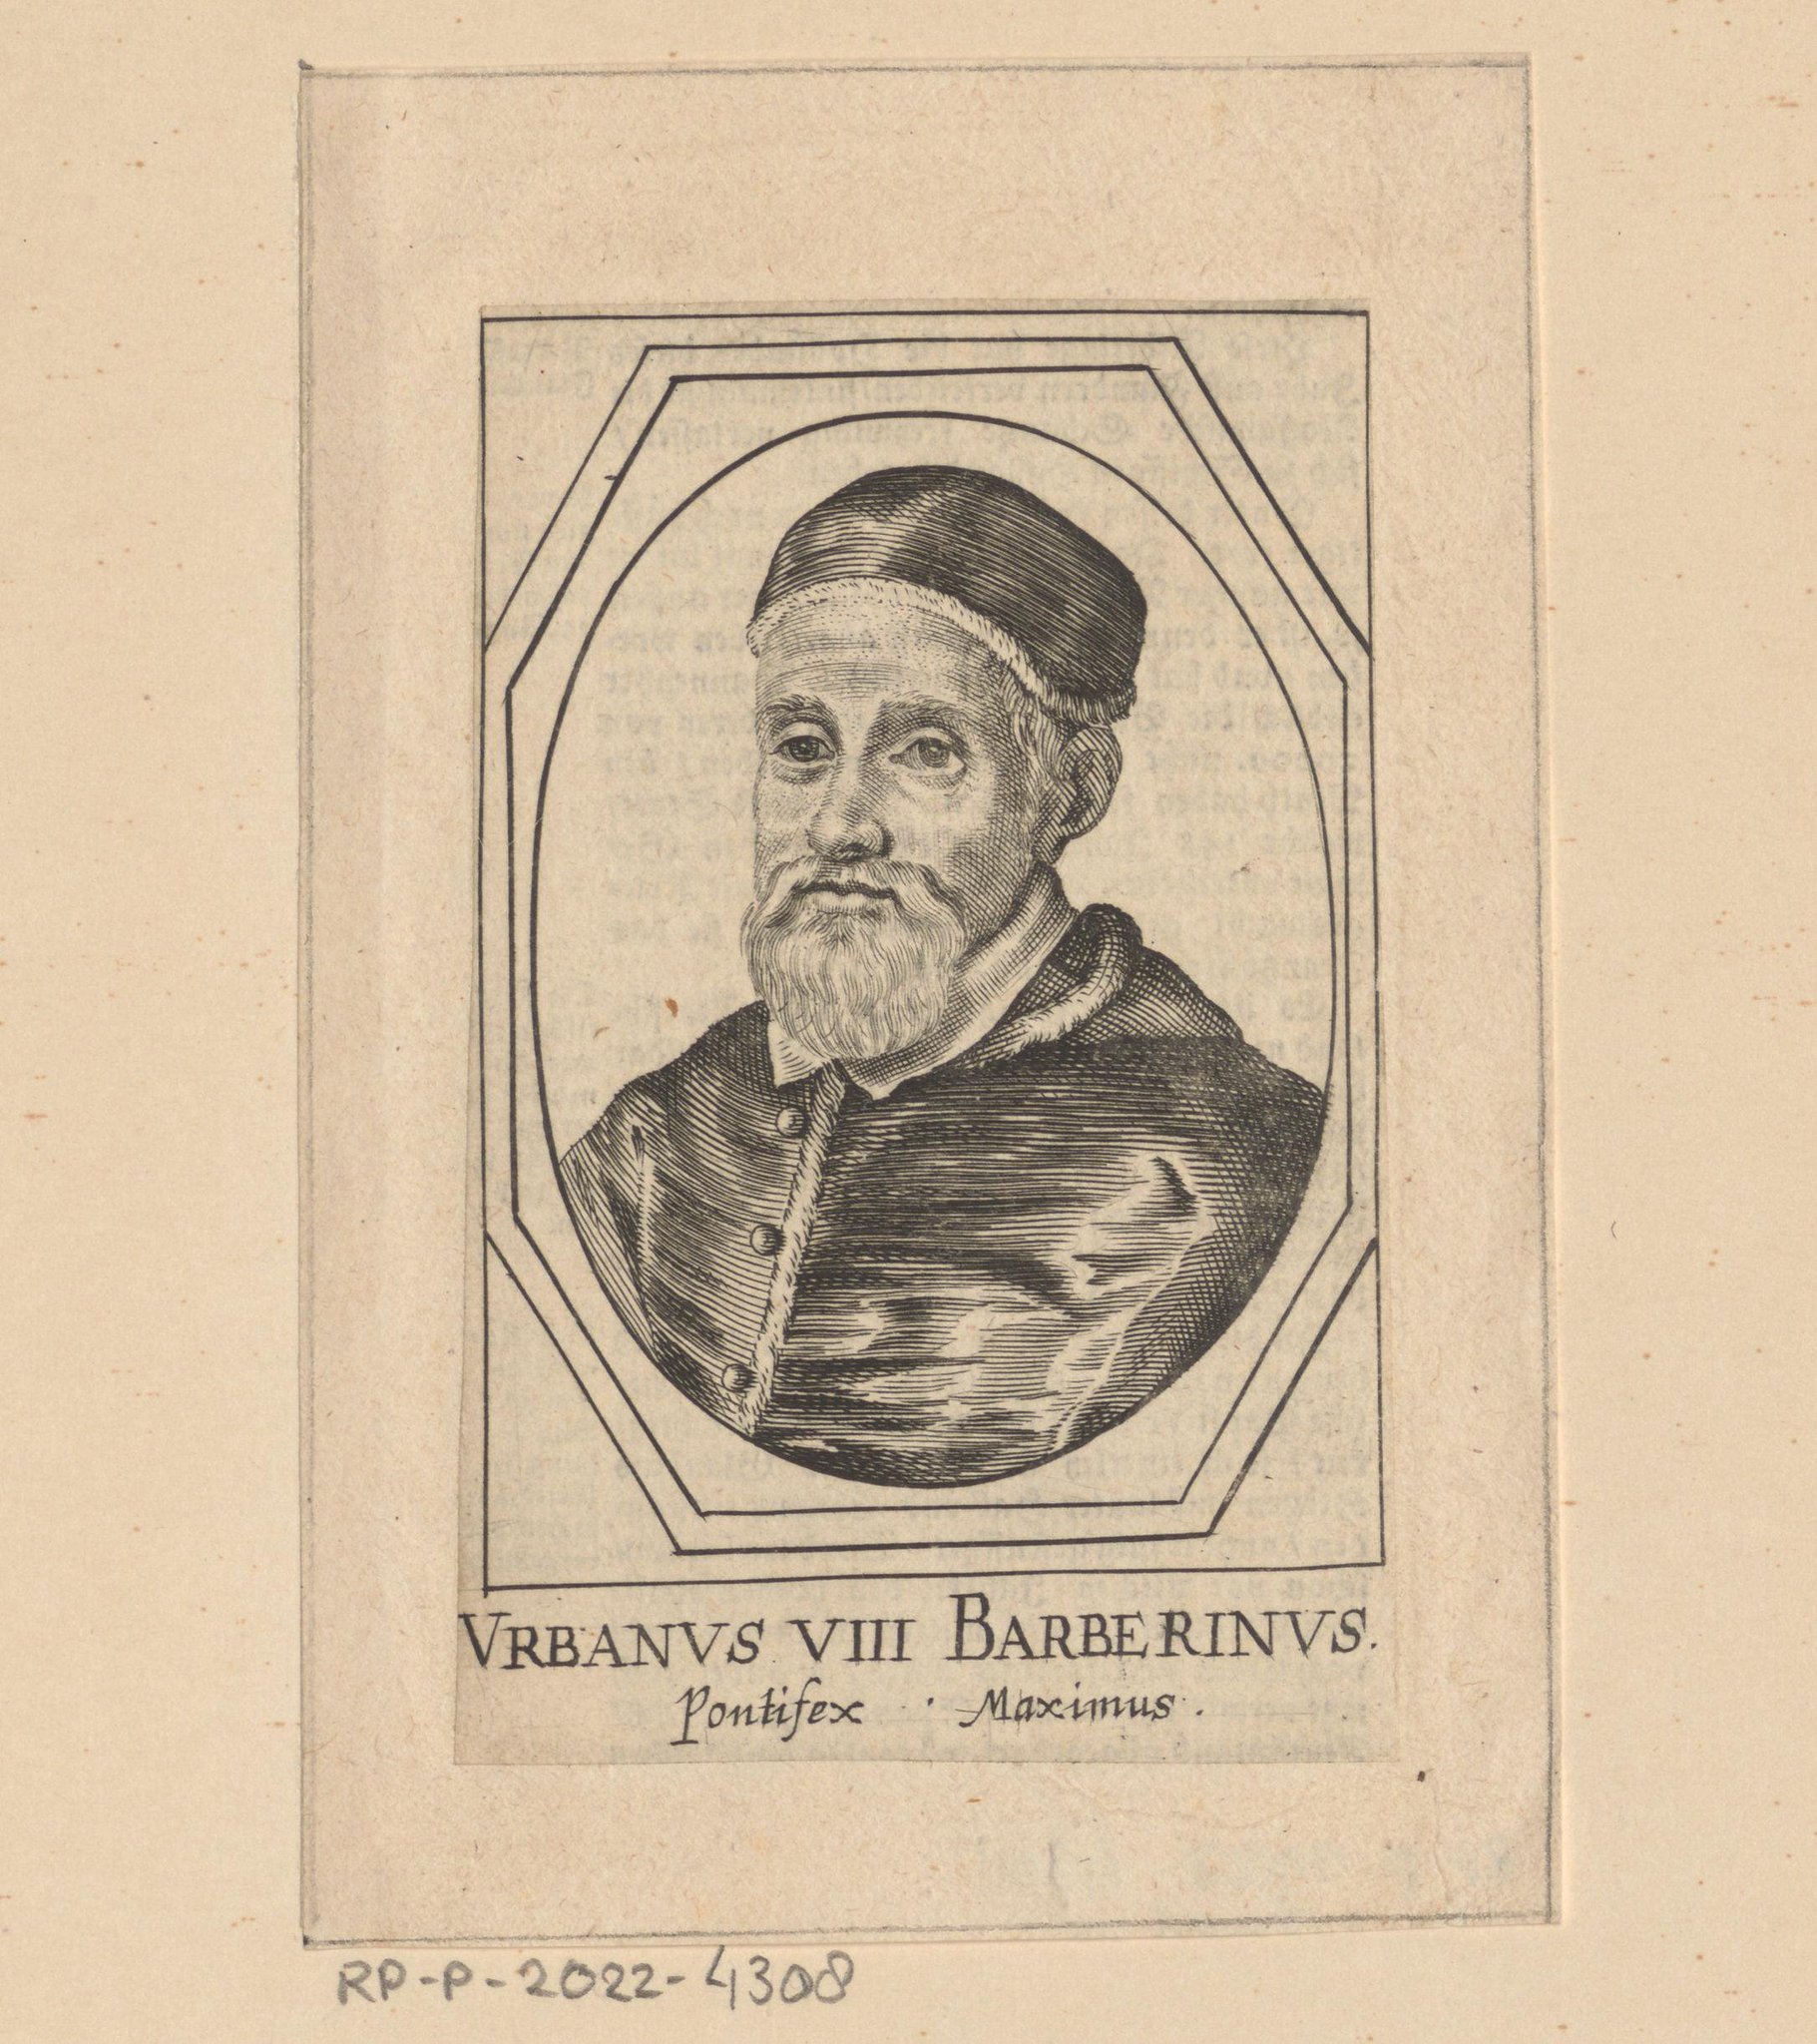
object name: book illustration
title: Portret van paus Urbanus VIII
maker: Anonymous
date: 1655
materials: paper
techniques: engraving, letterpress printing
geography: northern netherlands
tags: rome, clergyman, urbanus viii, historical persons, pope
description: Prent mogelijk uit: Brachelius, Johannes Adolphus. Historiarum nostri temporis editio ultima (…). Amsterdam: Jacob van Meurs en Johannes Janssonius, 1655.